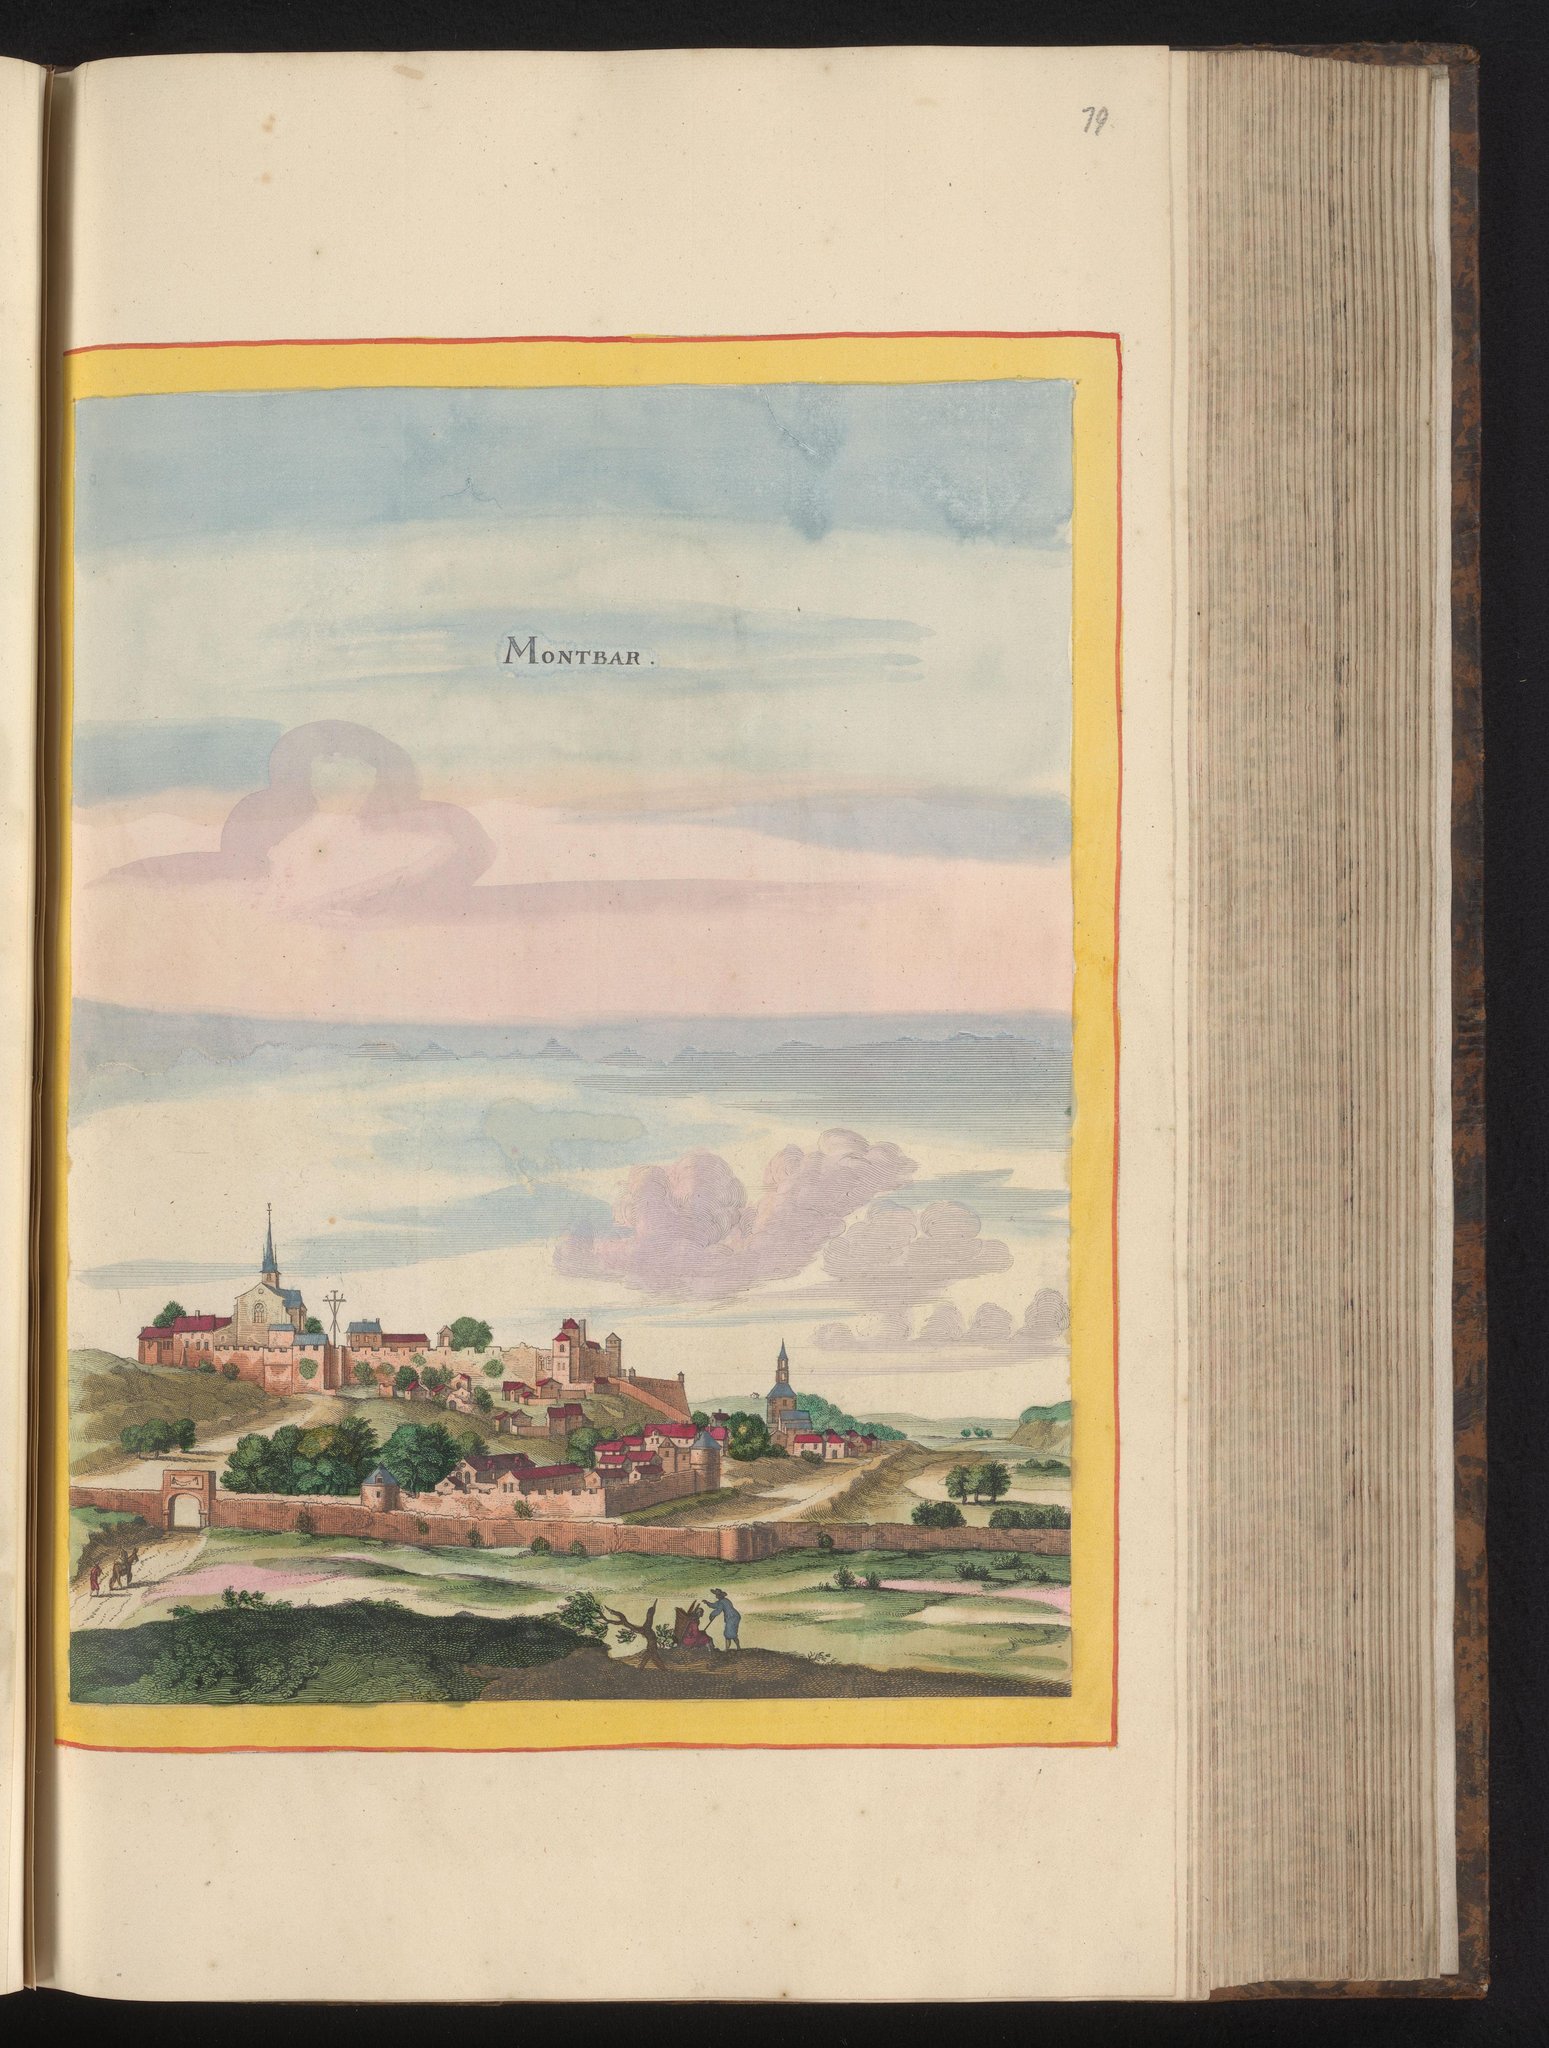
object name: print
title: Montbar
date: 1656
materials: paper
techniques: engraving, etching, hand coloring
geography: the hague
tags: city-view in general; 'veduta'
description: Prent uit: Zeiller, Martin. Topographia Galliae. 13 dln. Frankfurt: Caspar Merian, 1656, dl. 3, na p. 22.